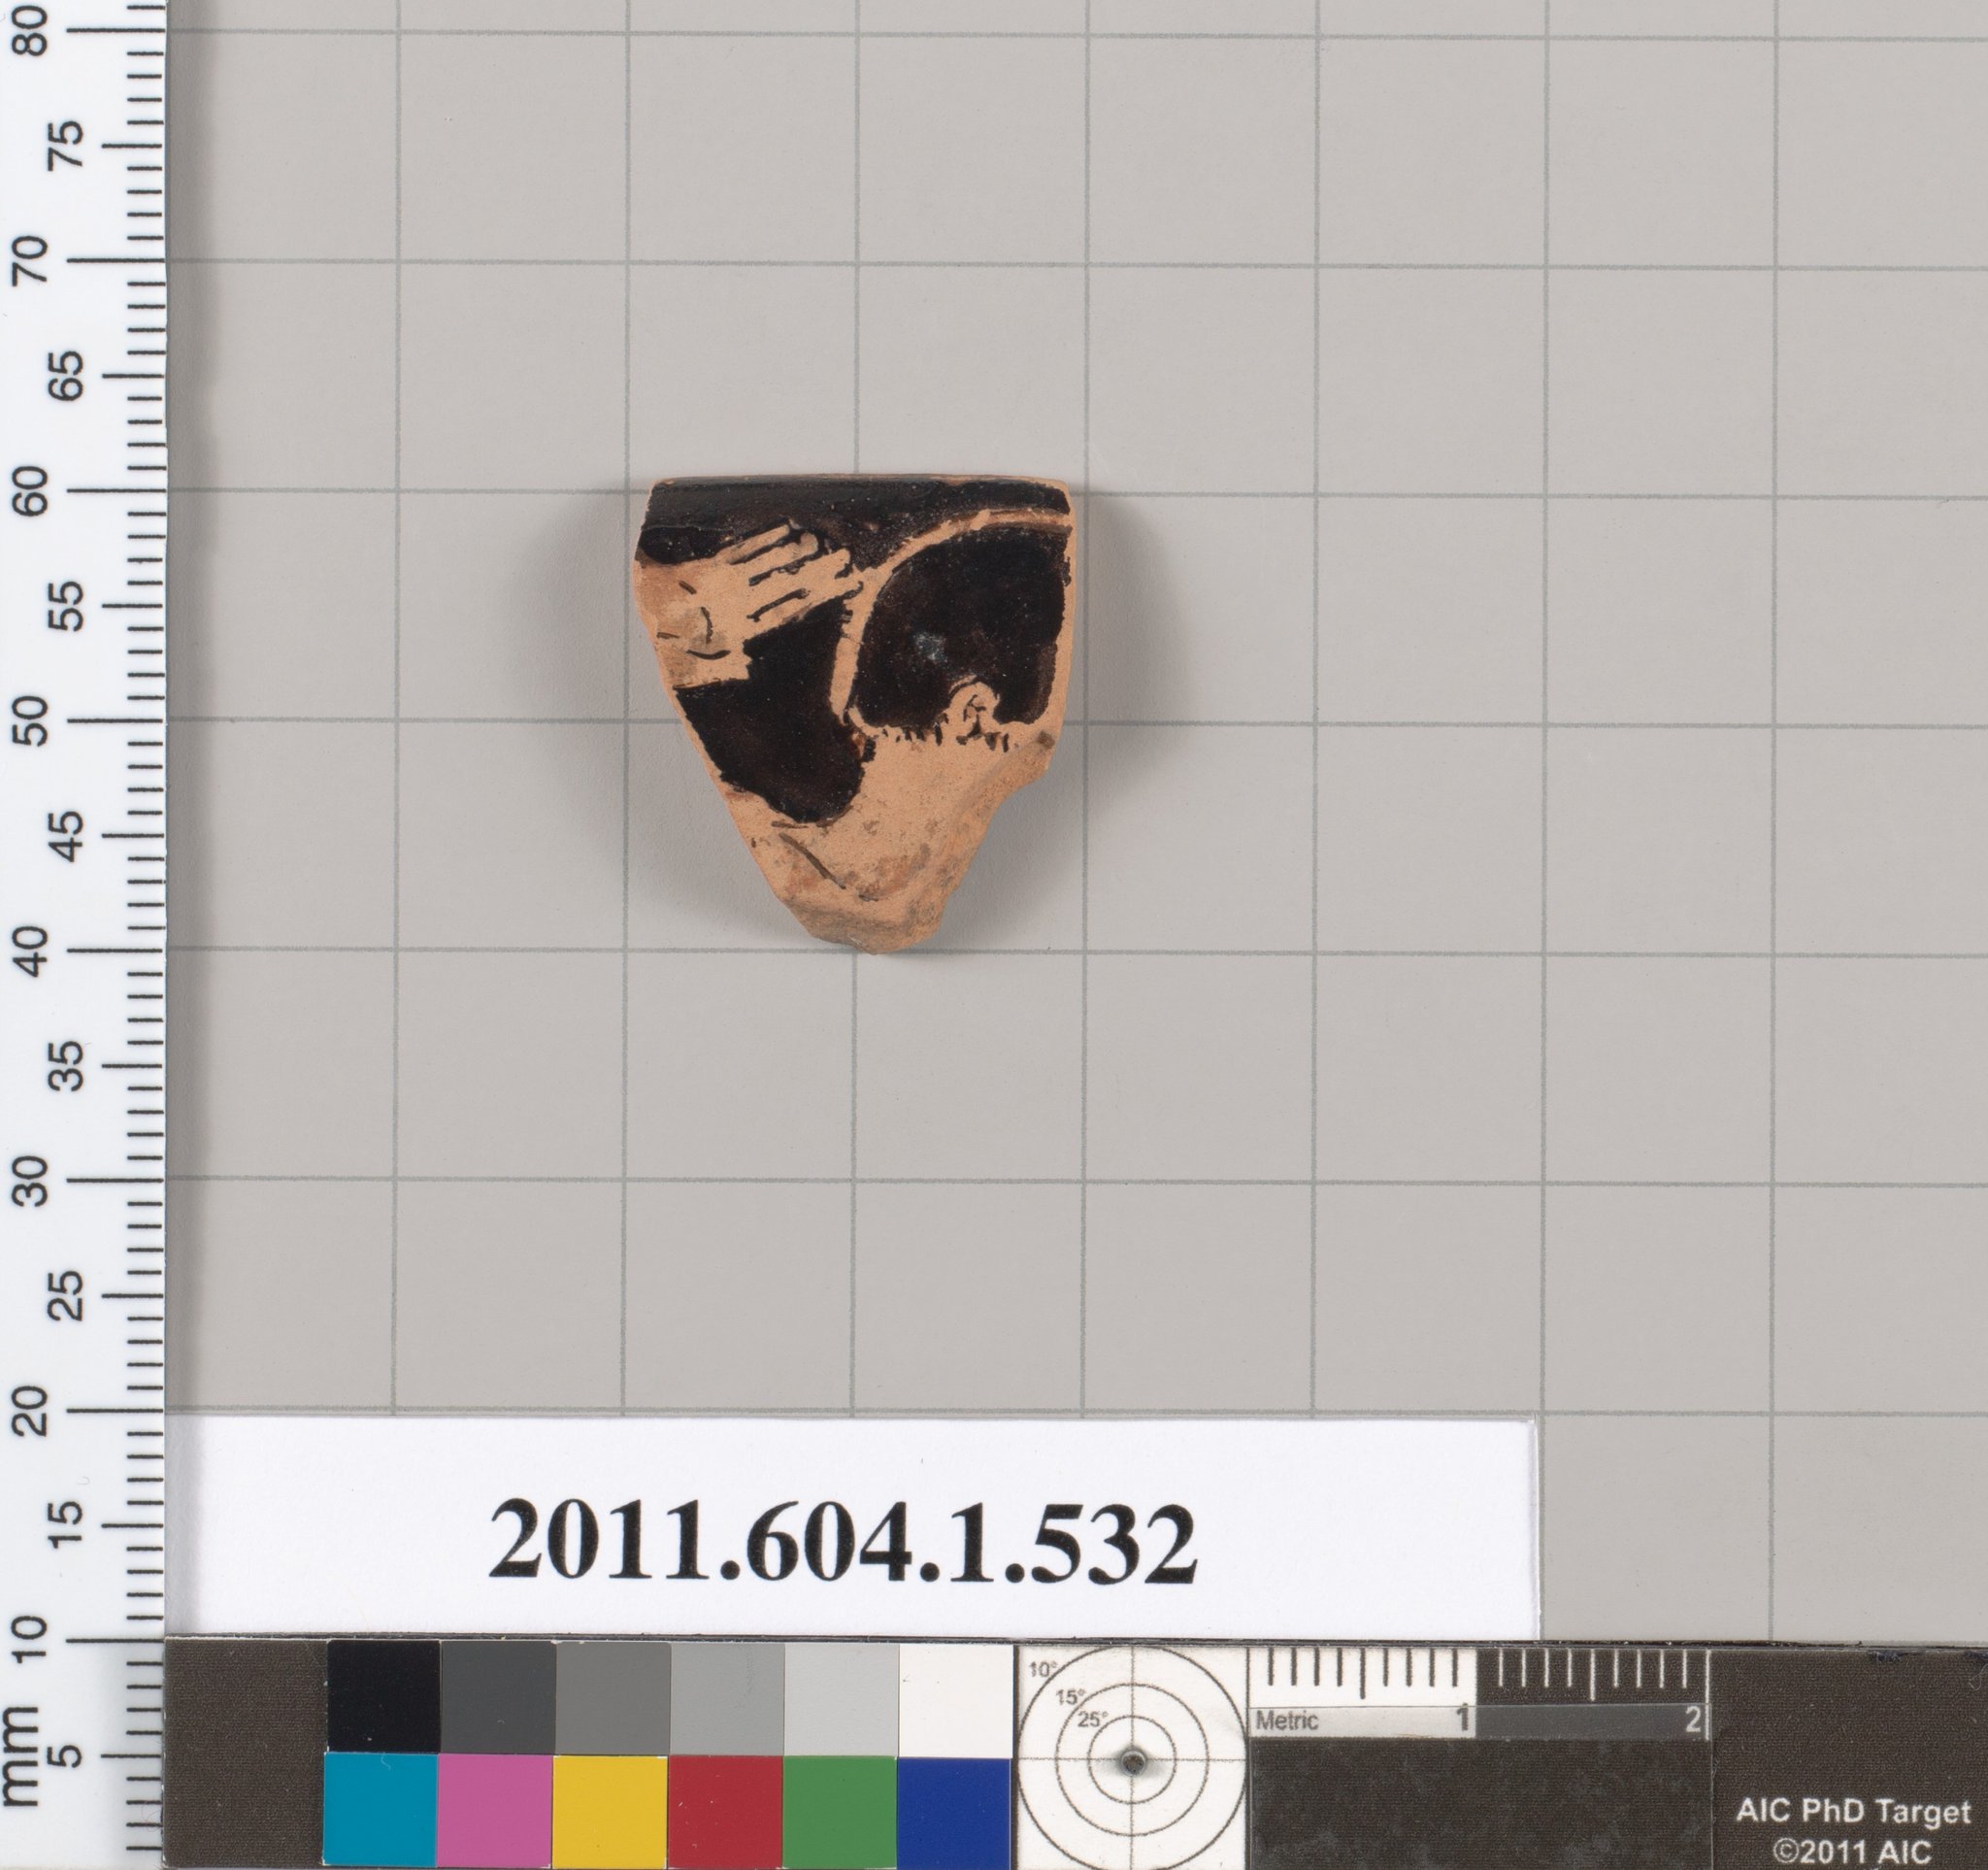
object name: kylix fragment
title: Terracotta rim fragment of a kylix (drinking cup)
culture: greek, attic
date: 480-470 BCE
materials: terracotta